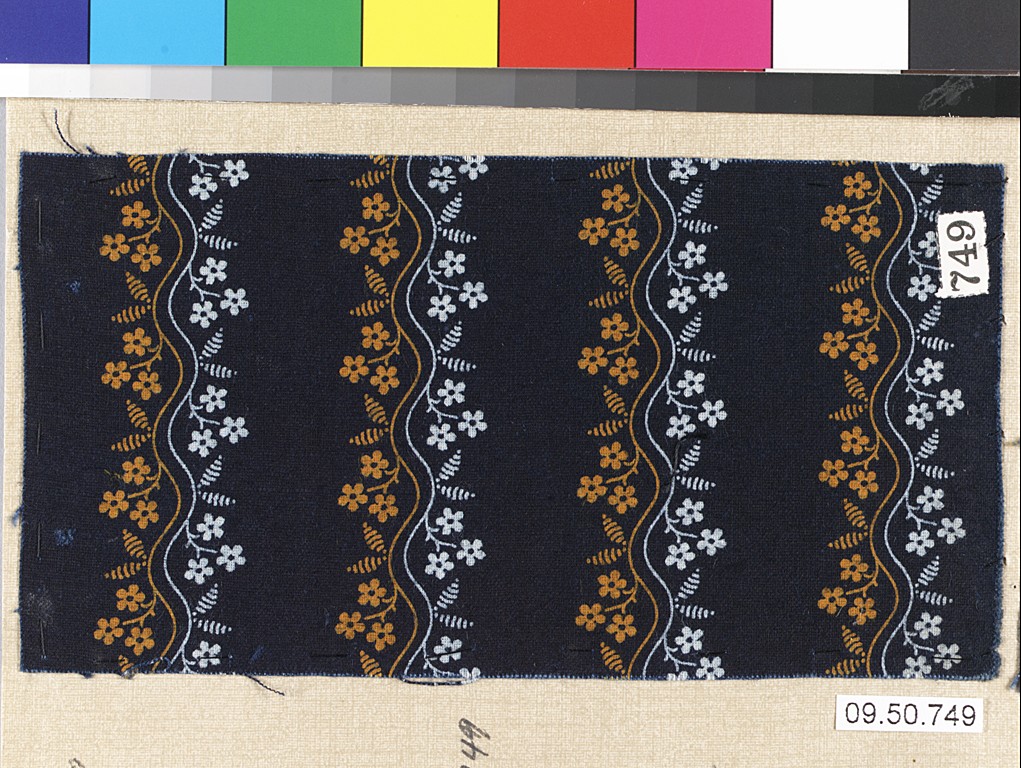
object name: piece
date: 1801-1900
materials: cotton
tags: flowers,leaves